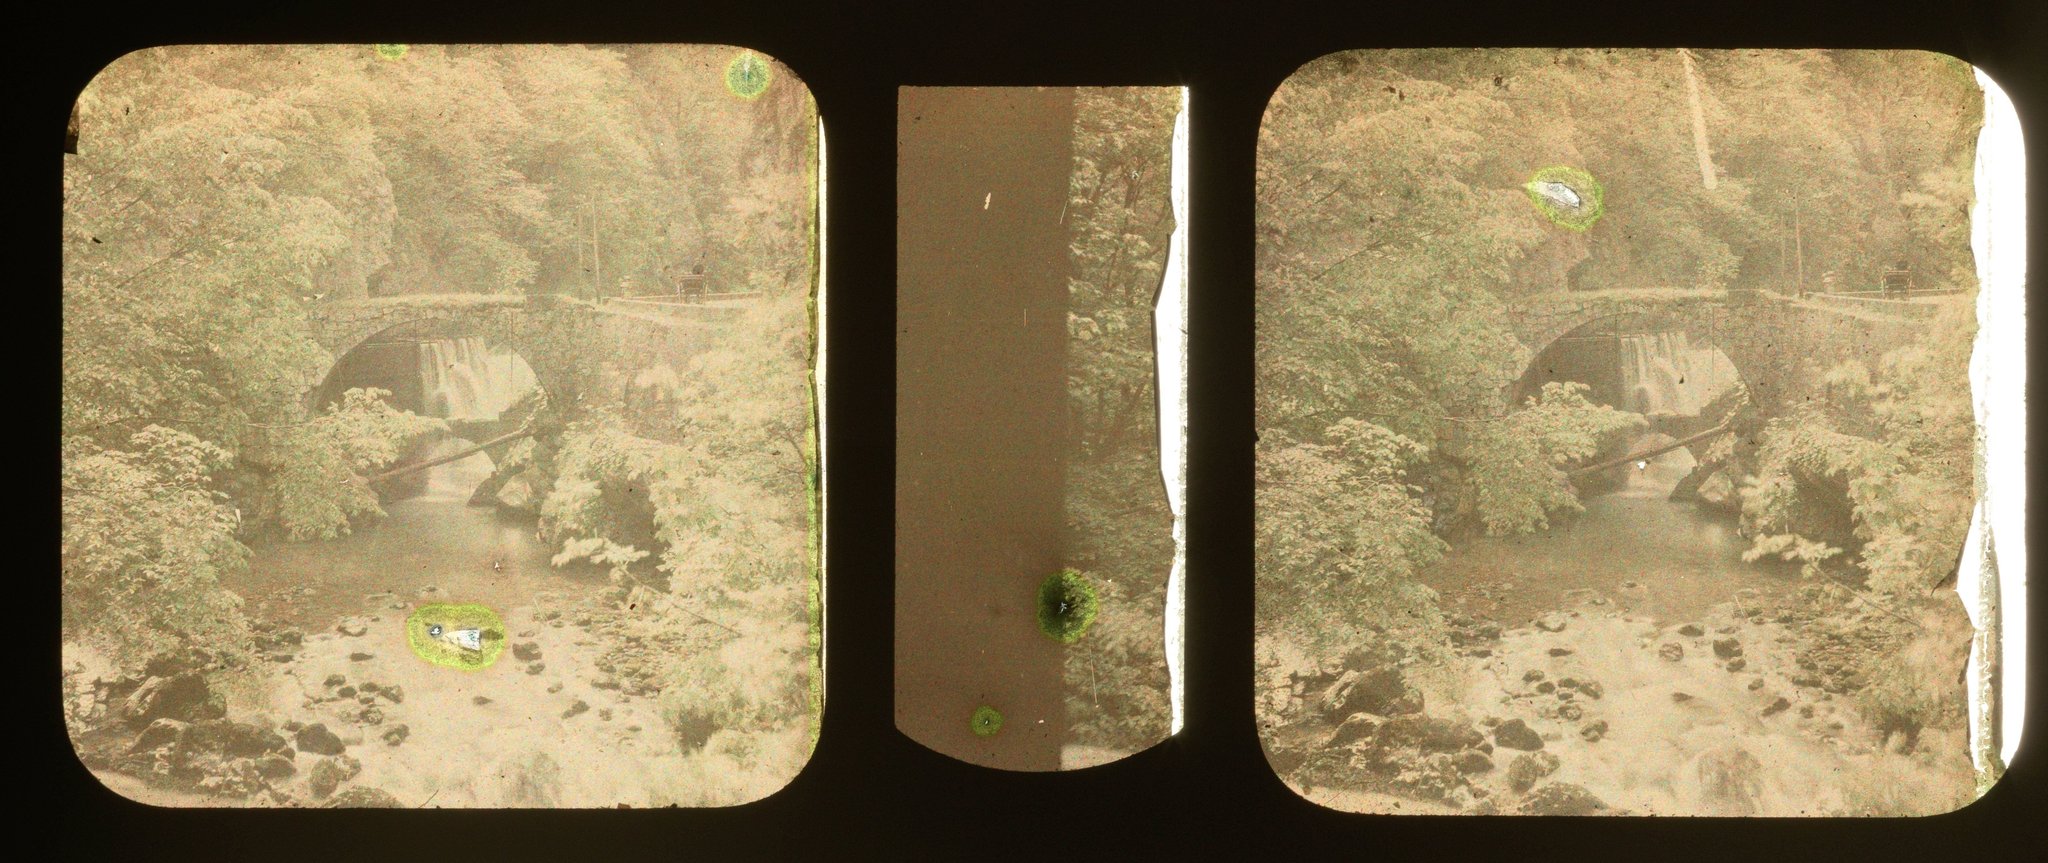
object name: stereoscopic photograph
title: Brug over een beek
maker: adolphe burdet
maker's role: fotograaf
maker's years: 1860-1940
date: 1907-1935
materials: glass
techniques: autochrome process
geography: france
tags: brook, france